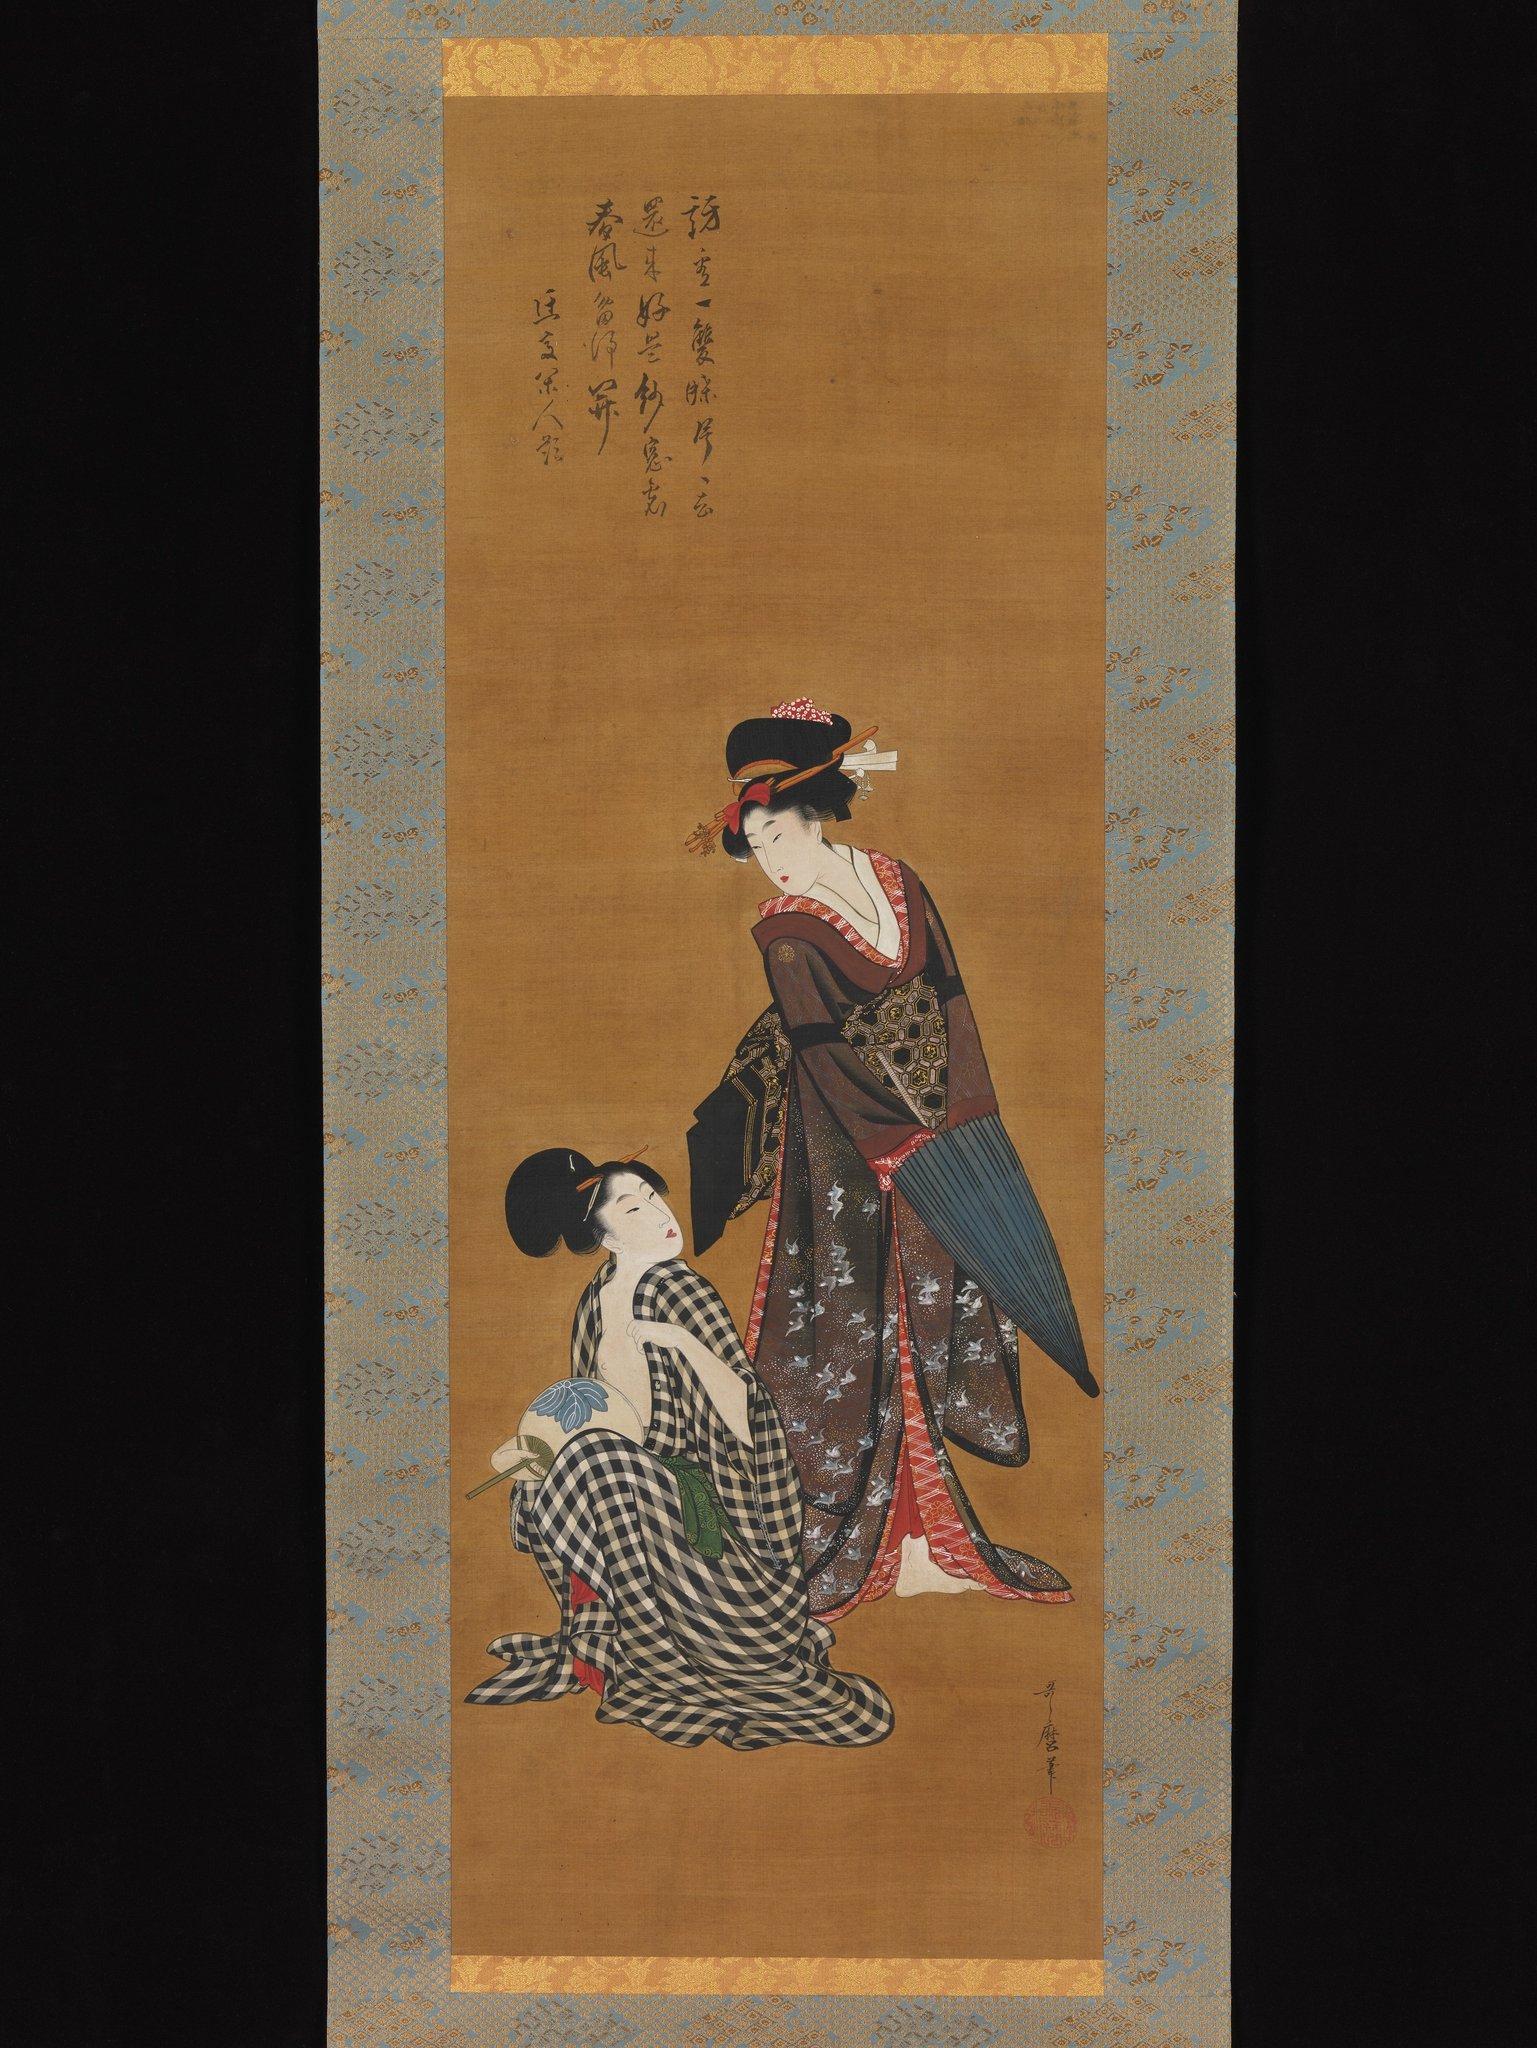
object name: hanging scroll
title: Two Beauties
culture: japanese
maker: kitagawa utamaro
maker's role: artist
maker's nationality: japanese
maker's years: 1754-1806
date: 1801-1804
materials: ink, silk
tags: women